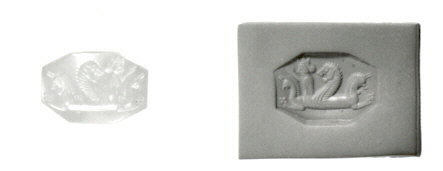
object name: stamp seal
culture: achaemenid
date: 500-401 BCE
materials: stone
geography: iran